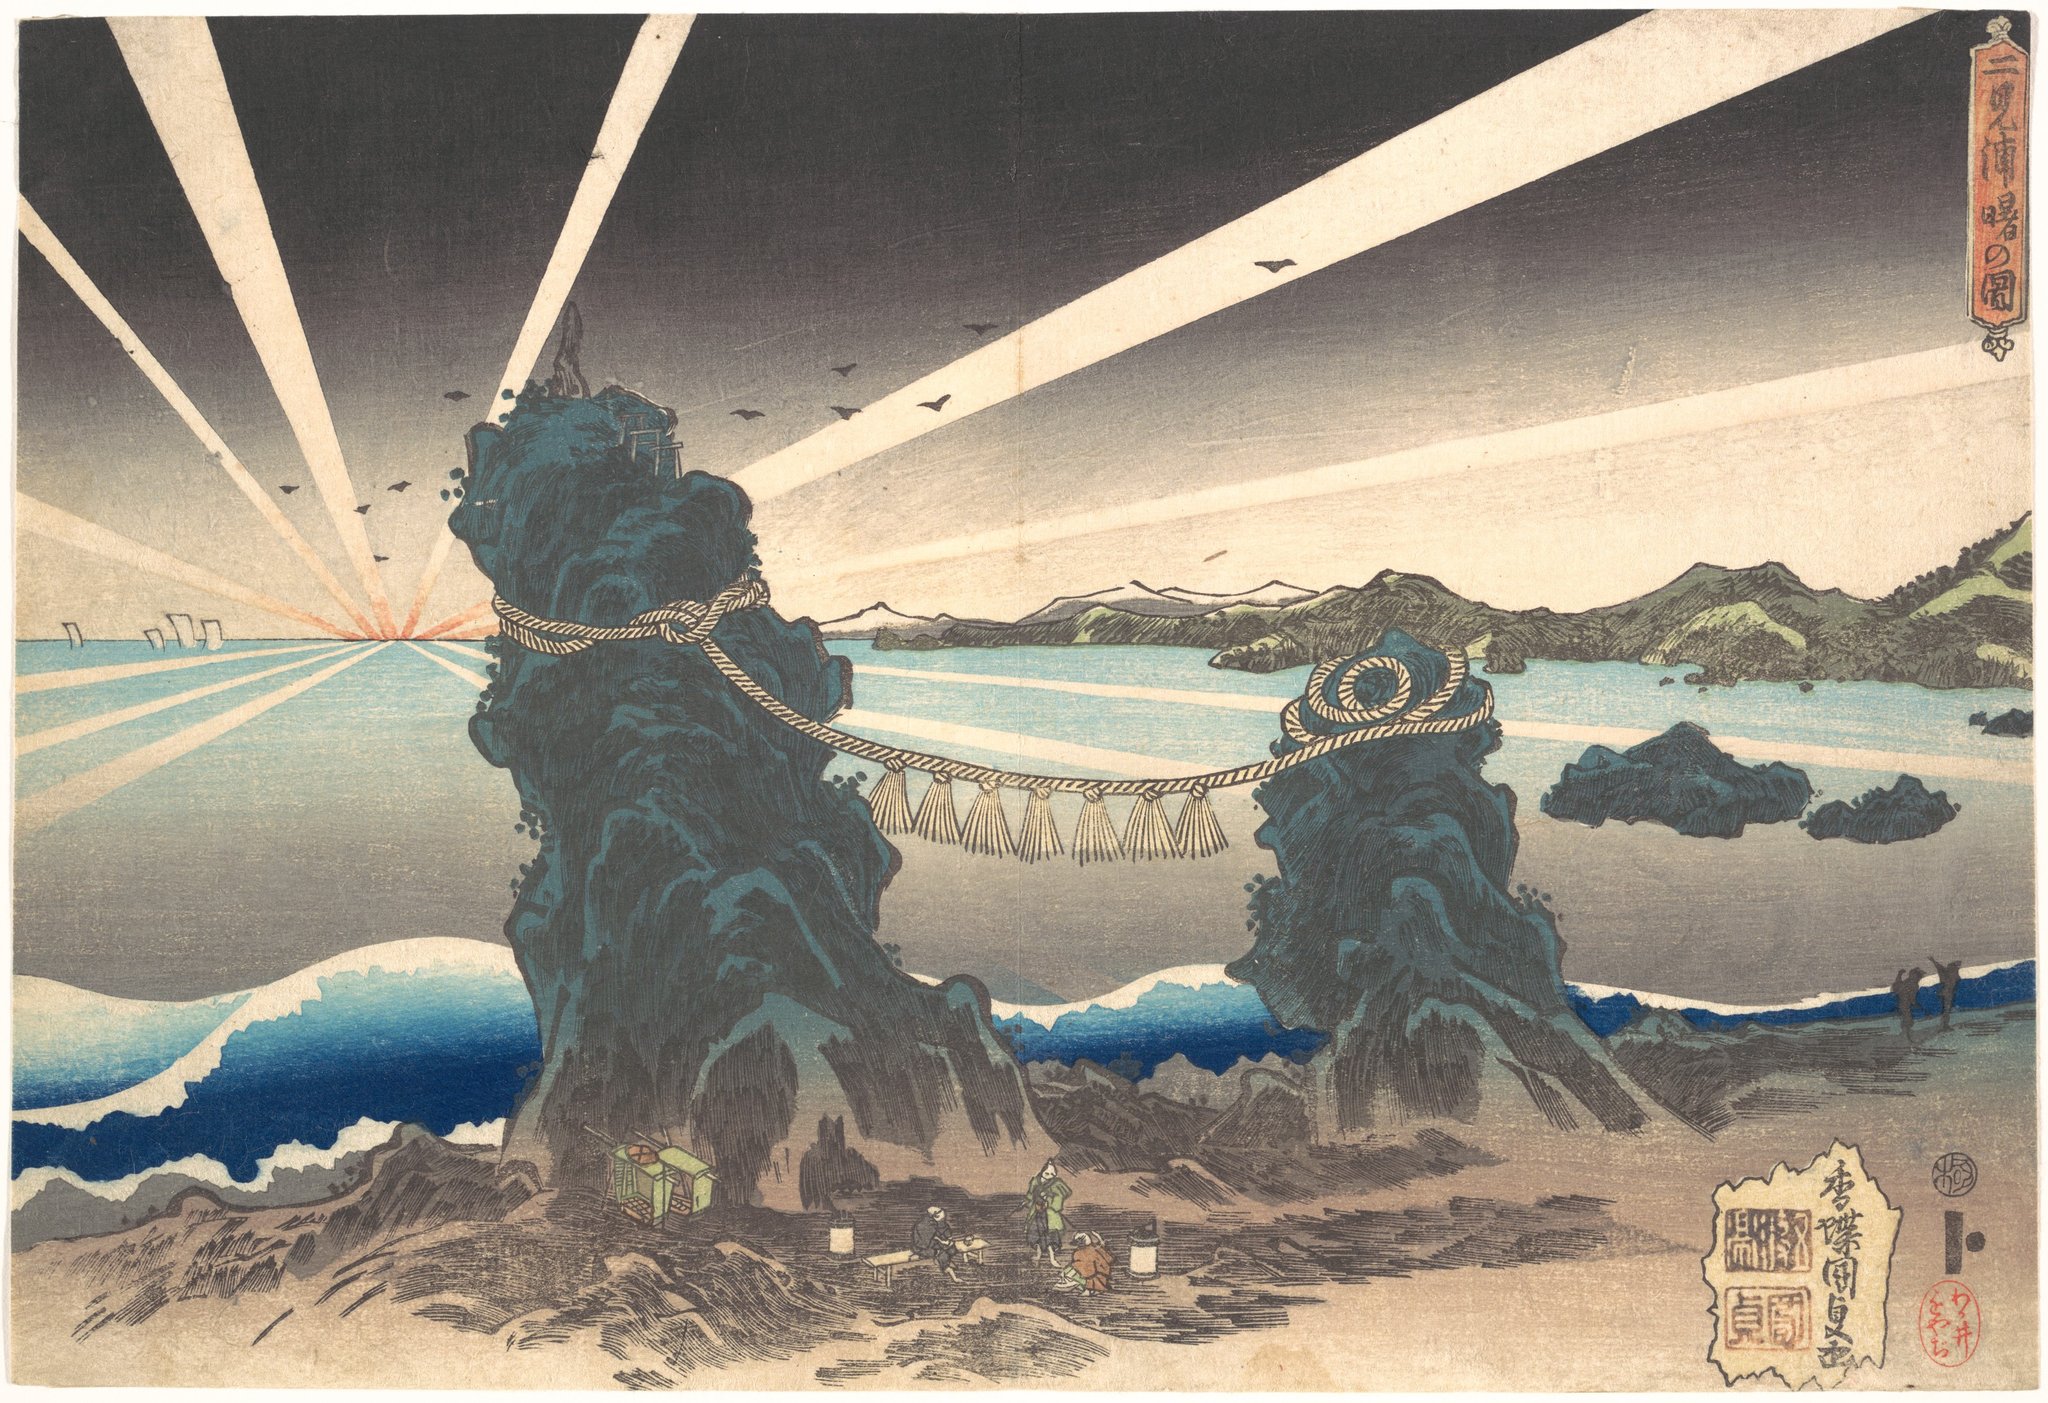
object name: print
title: Futami-ga-ura Rocks at Ise, Land of Dawn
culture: japanese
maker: utagawa kunisada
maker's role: artist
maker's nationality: japanese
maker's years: 1786-1864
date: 1835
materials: ink, paper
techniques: woodblock print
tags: birds,mountains,dawn